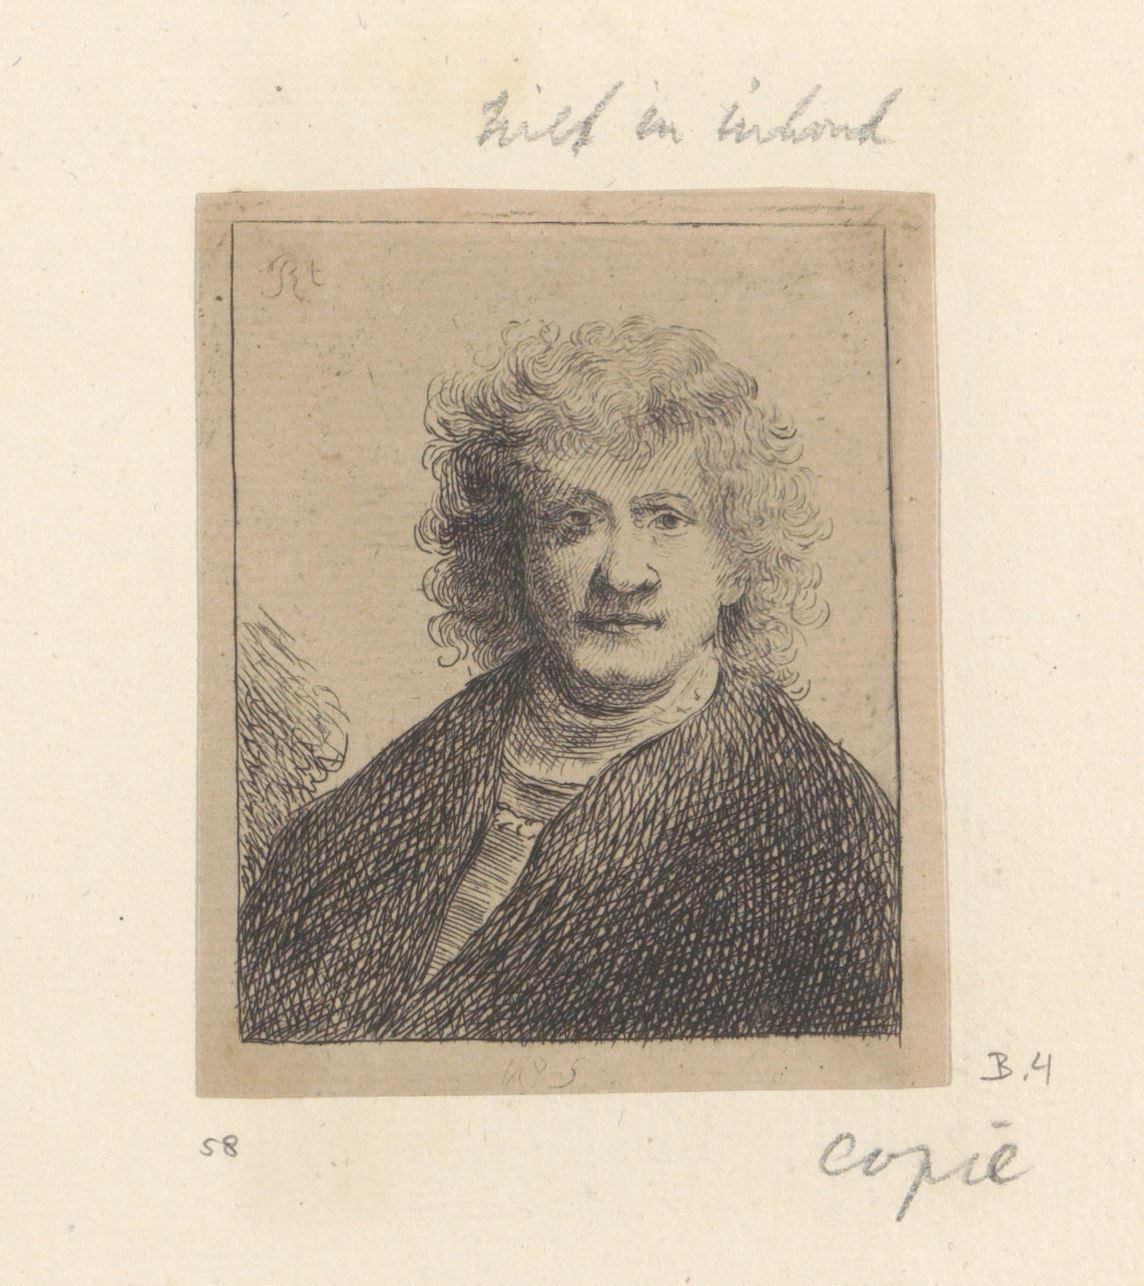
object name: album leaf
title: Recueil de quatre-vingt-cinq estampes originales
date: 1750-1797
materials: paper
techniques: etching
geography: paris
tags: leiden, amsterdam, painter, print maker, draughtsman, rembrandt van rijn